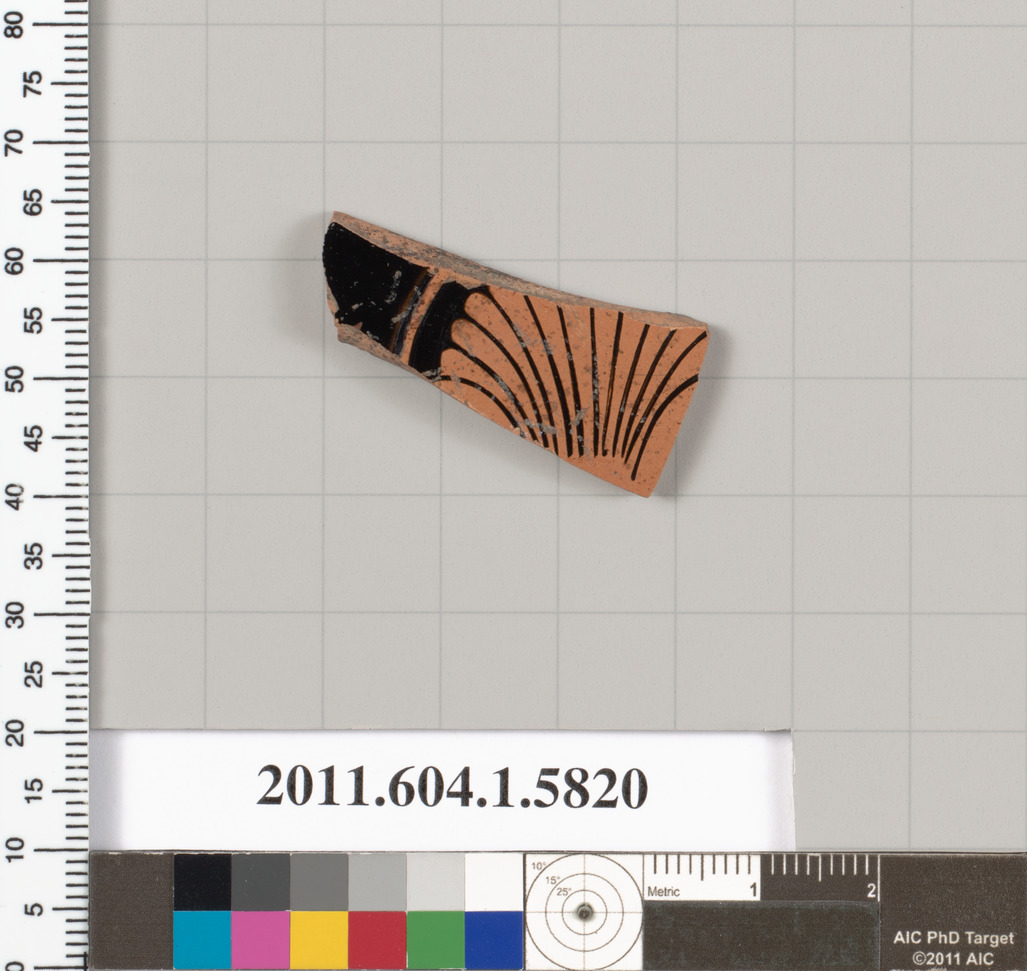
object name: kylix fragment, eye cup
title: Terracotta fragment of a kylix: eye-cup (drinking cup)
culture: greek, attic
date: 520-510 BCE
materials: terracotta